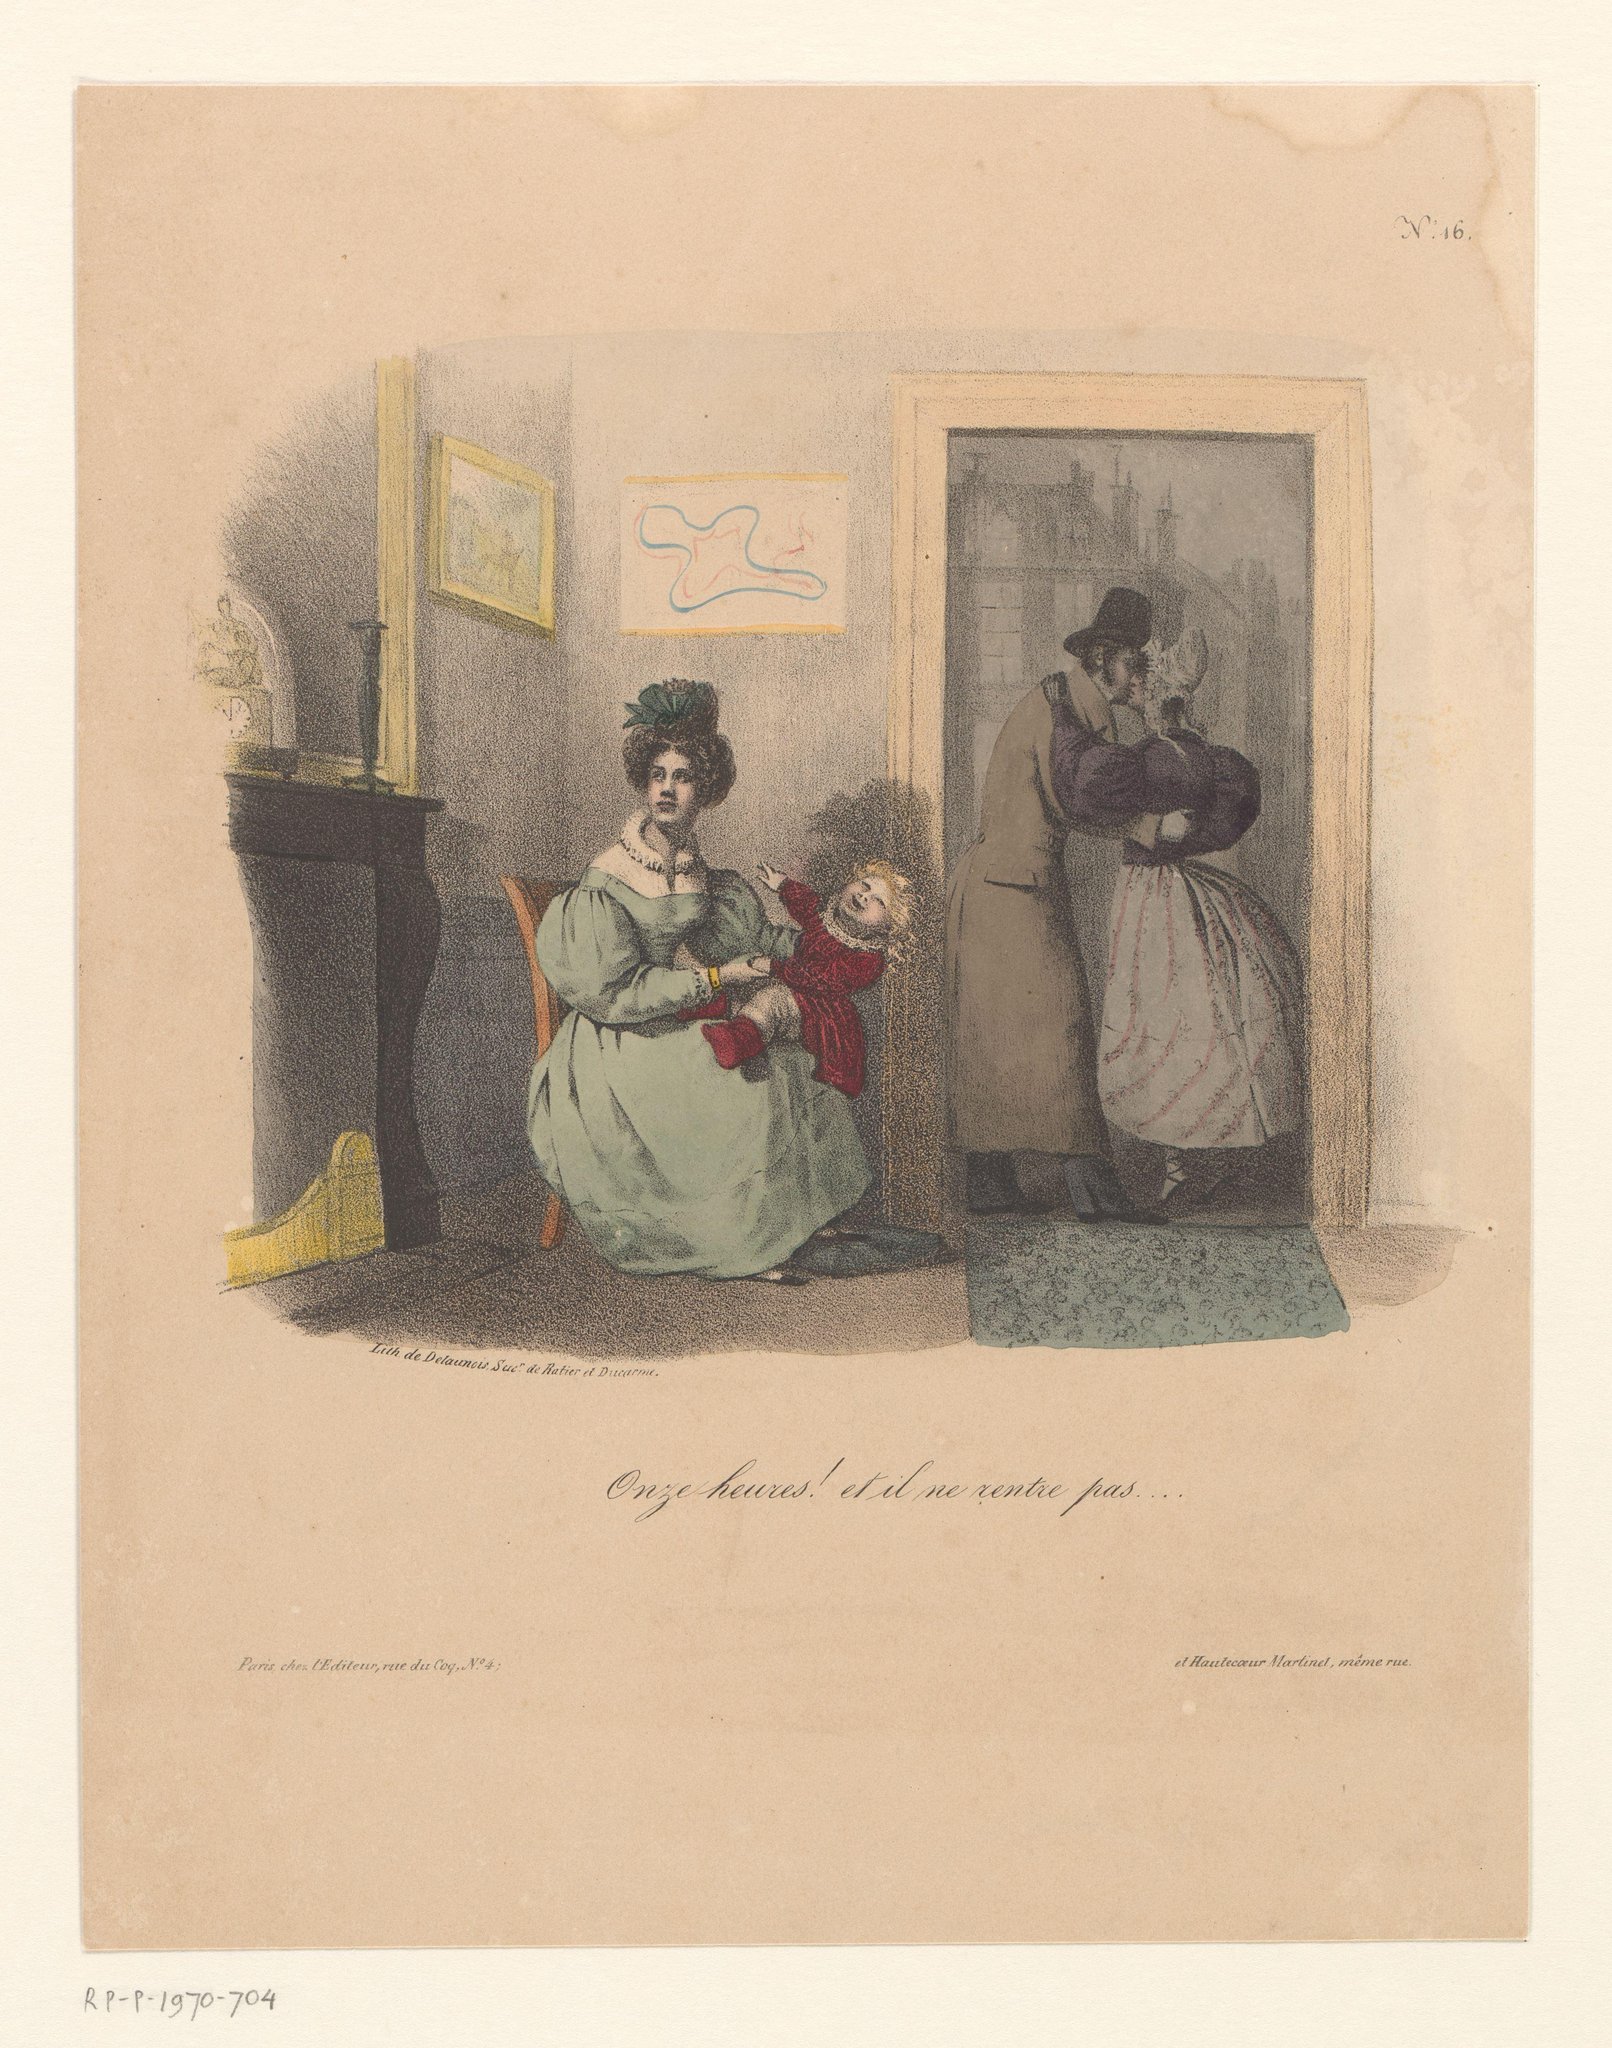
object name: cartoon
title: De bedrogen echtgenote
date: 1830-1831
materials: paper, watercolor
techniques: hand coloring, lithograph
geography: paris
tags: clothes, costume (+ children's clothes), bad husband, (lovers) kissing each other, mother and baby or young child, adultery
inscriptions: collector's mark: Lugt 2228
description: Vrouw zit met kind op schoot te wachten op de terugkeer van haar echtgenoot, die in de deur een andere vrouw kust. Rechtsboven genummerd: No. 16.